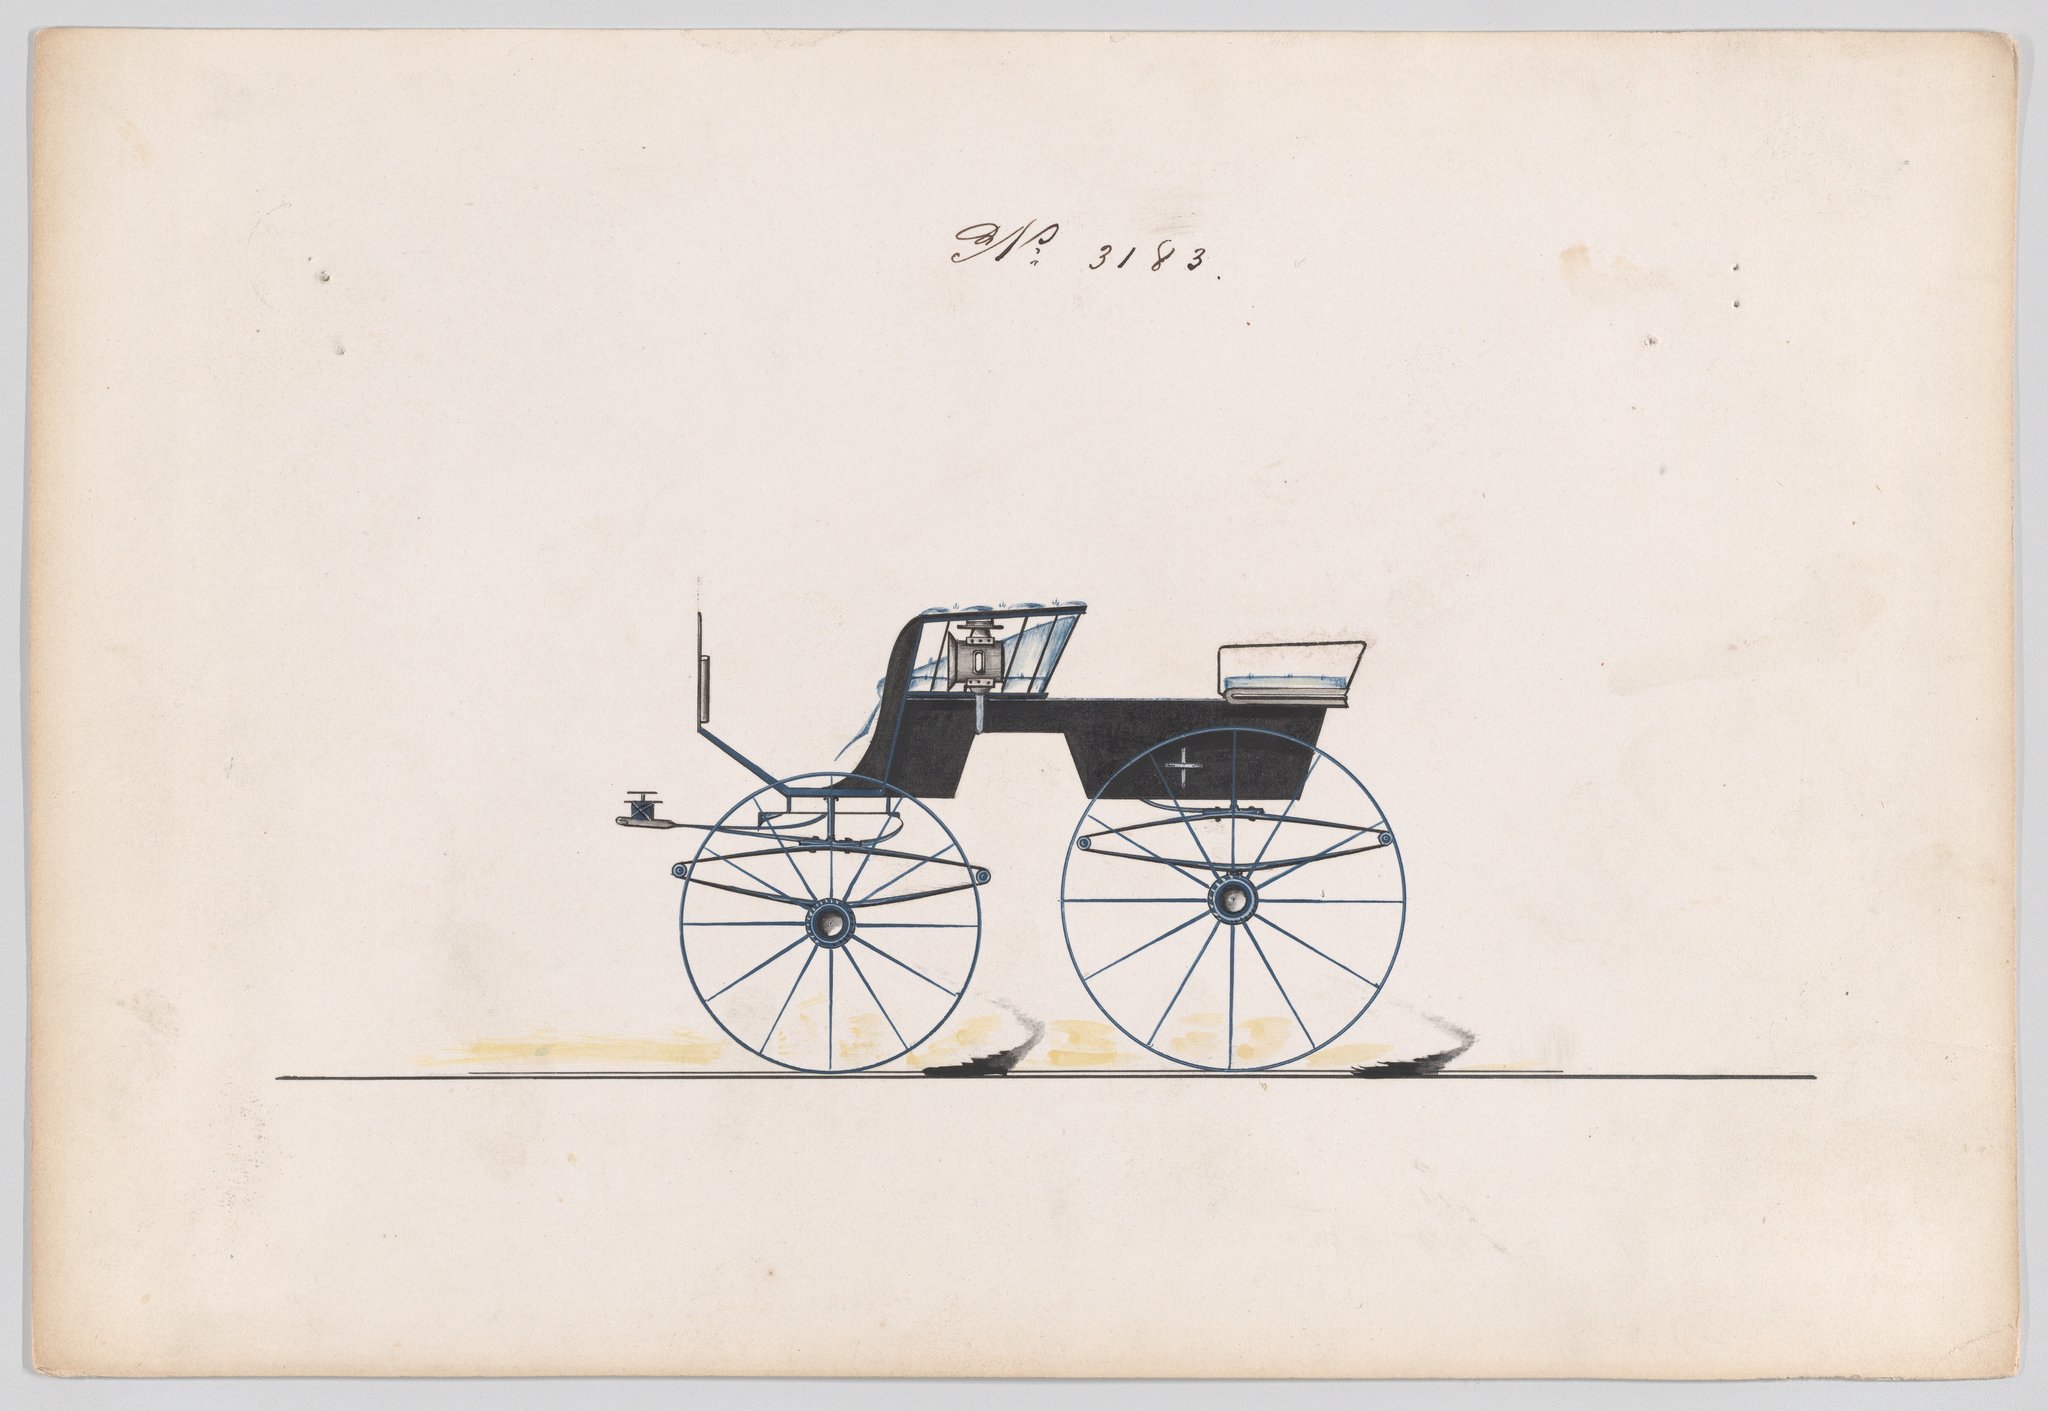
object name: drawing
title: Design for T-Cart, no. 3183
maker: brewster & co.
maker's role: manufacturer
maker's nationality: american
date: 1876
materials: gouache, gum arabic, ink, watercolor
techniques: pen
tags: carriages